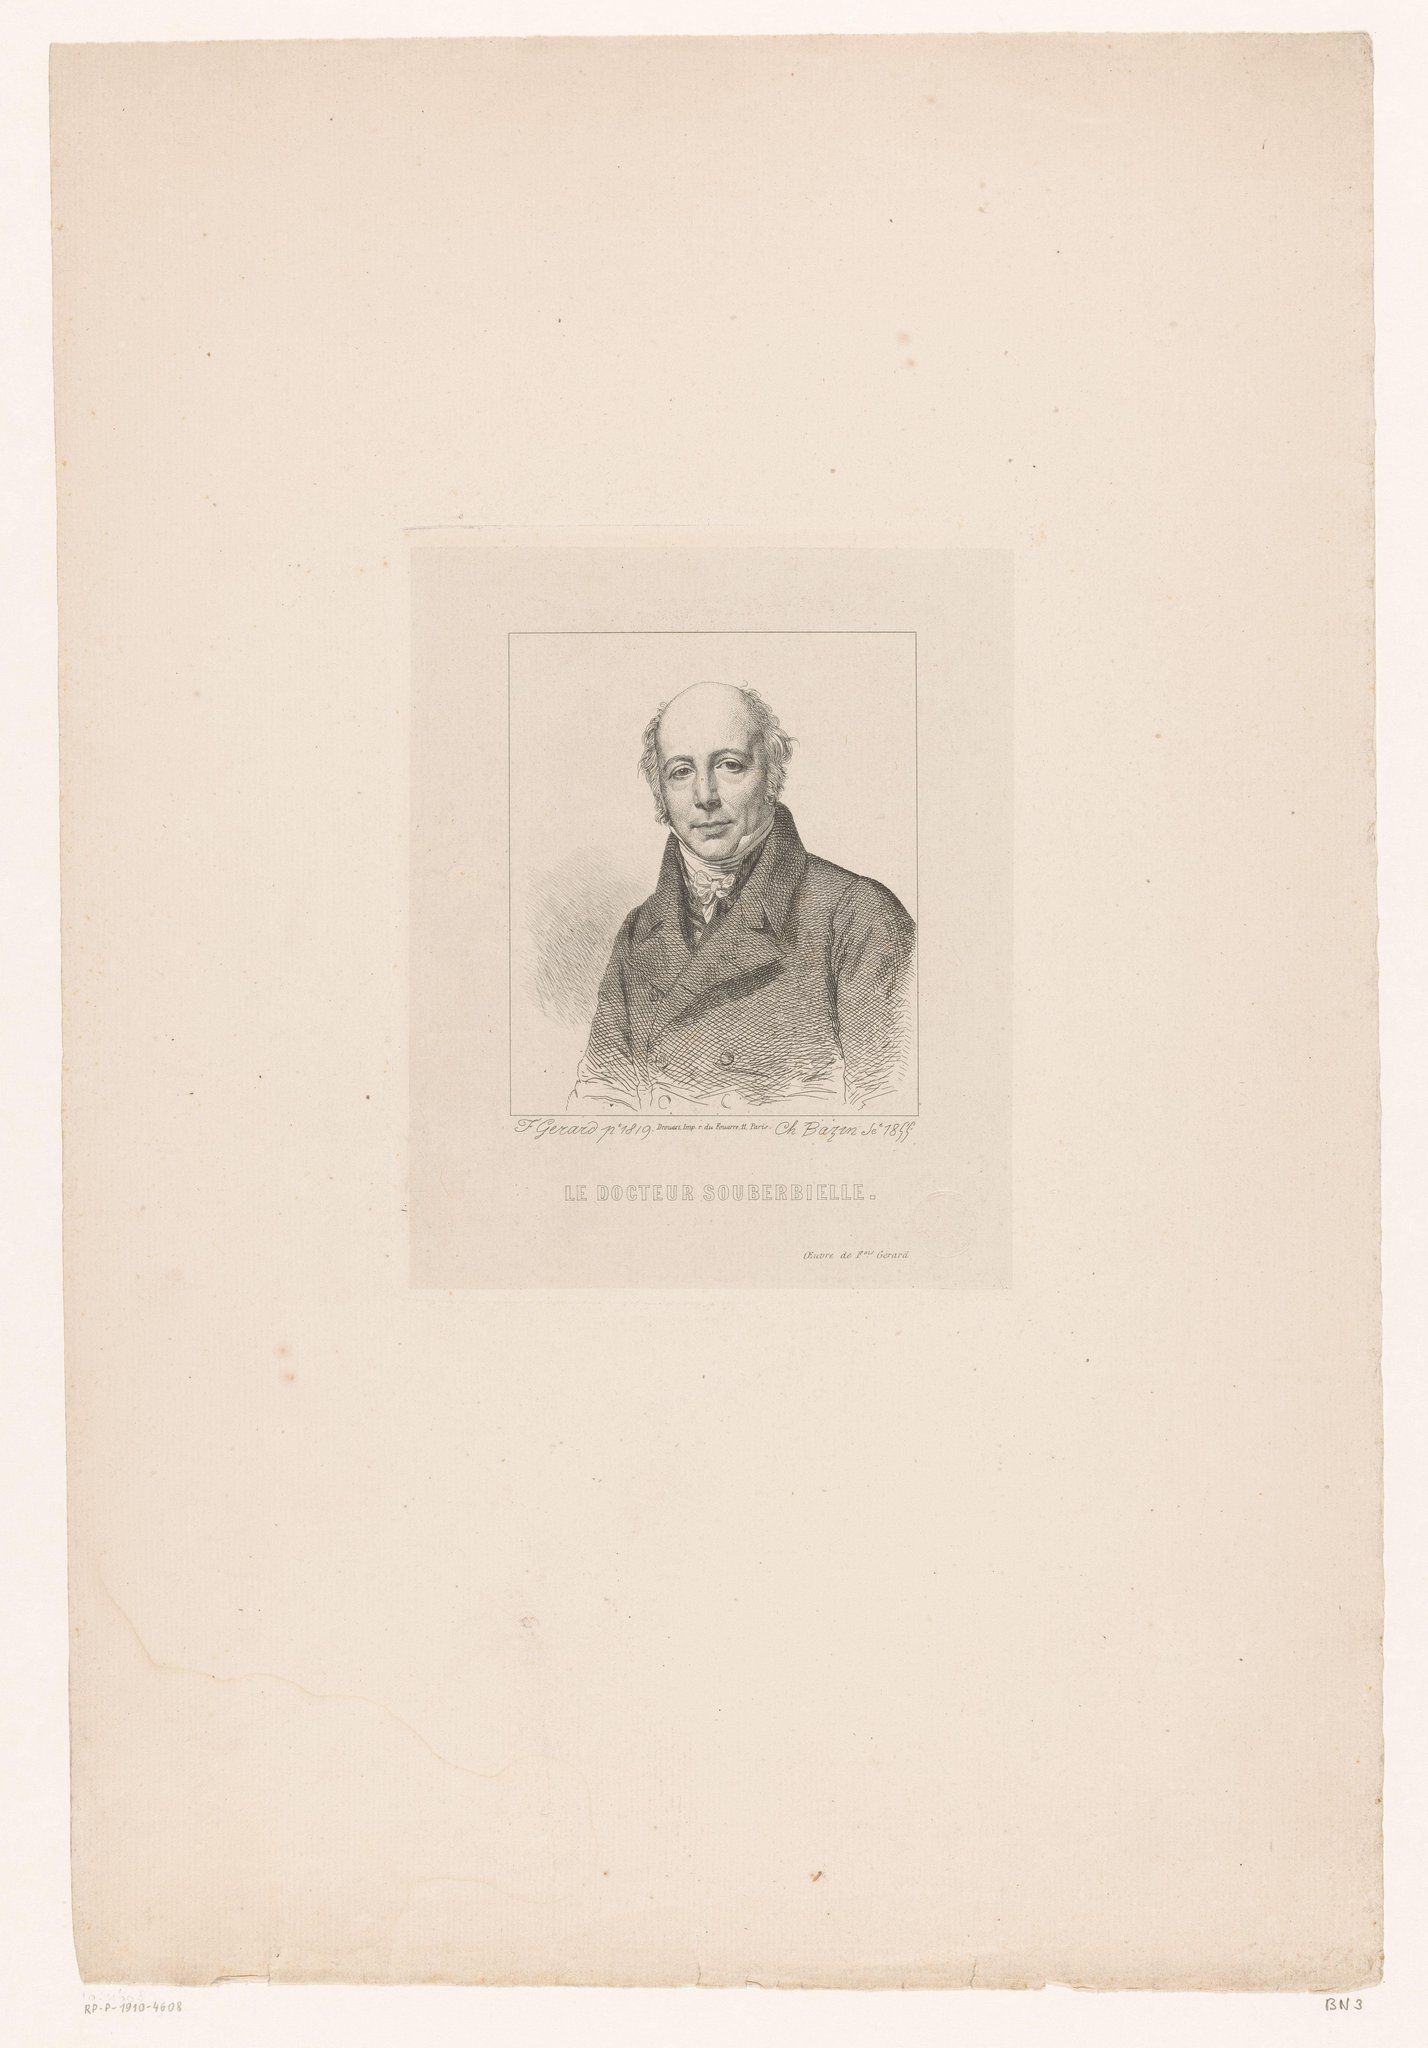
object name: print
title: Portret van Joseph Souberbielle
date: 1855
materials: paper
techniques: etching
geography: paris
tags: paris, historical persons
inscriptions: collector's mark: Lugt 2228, collector's mark: Lugt 4336